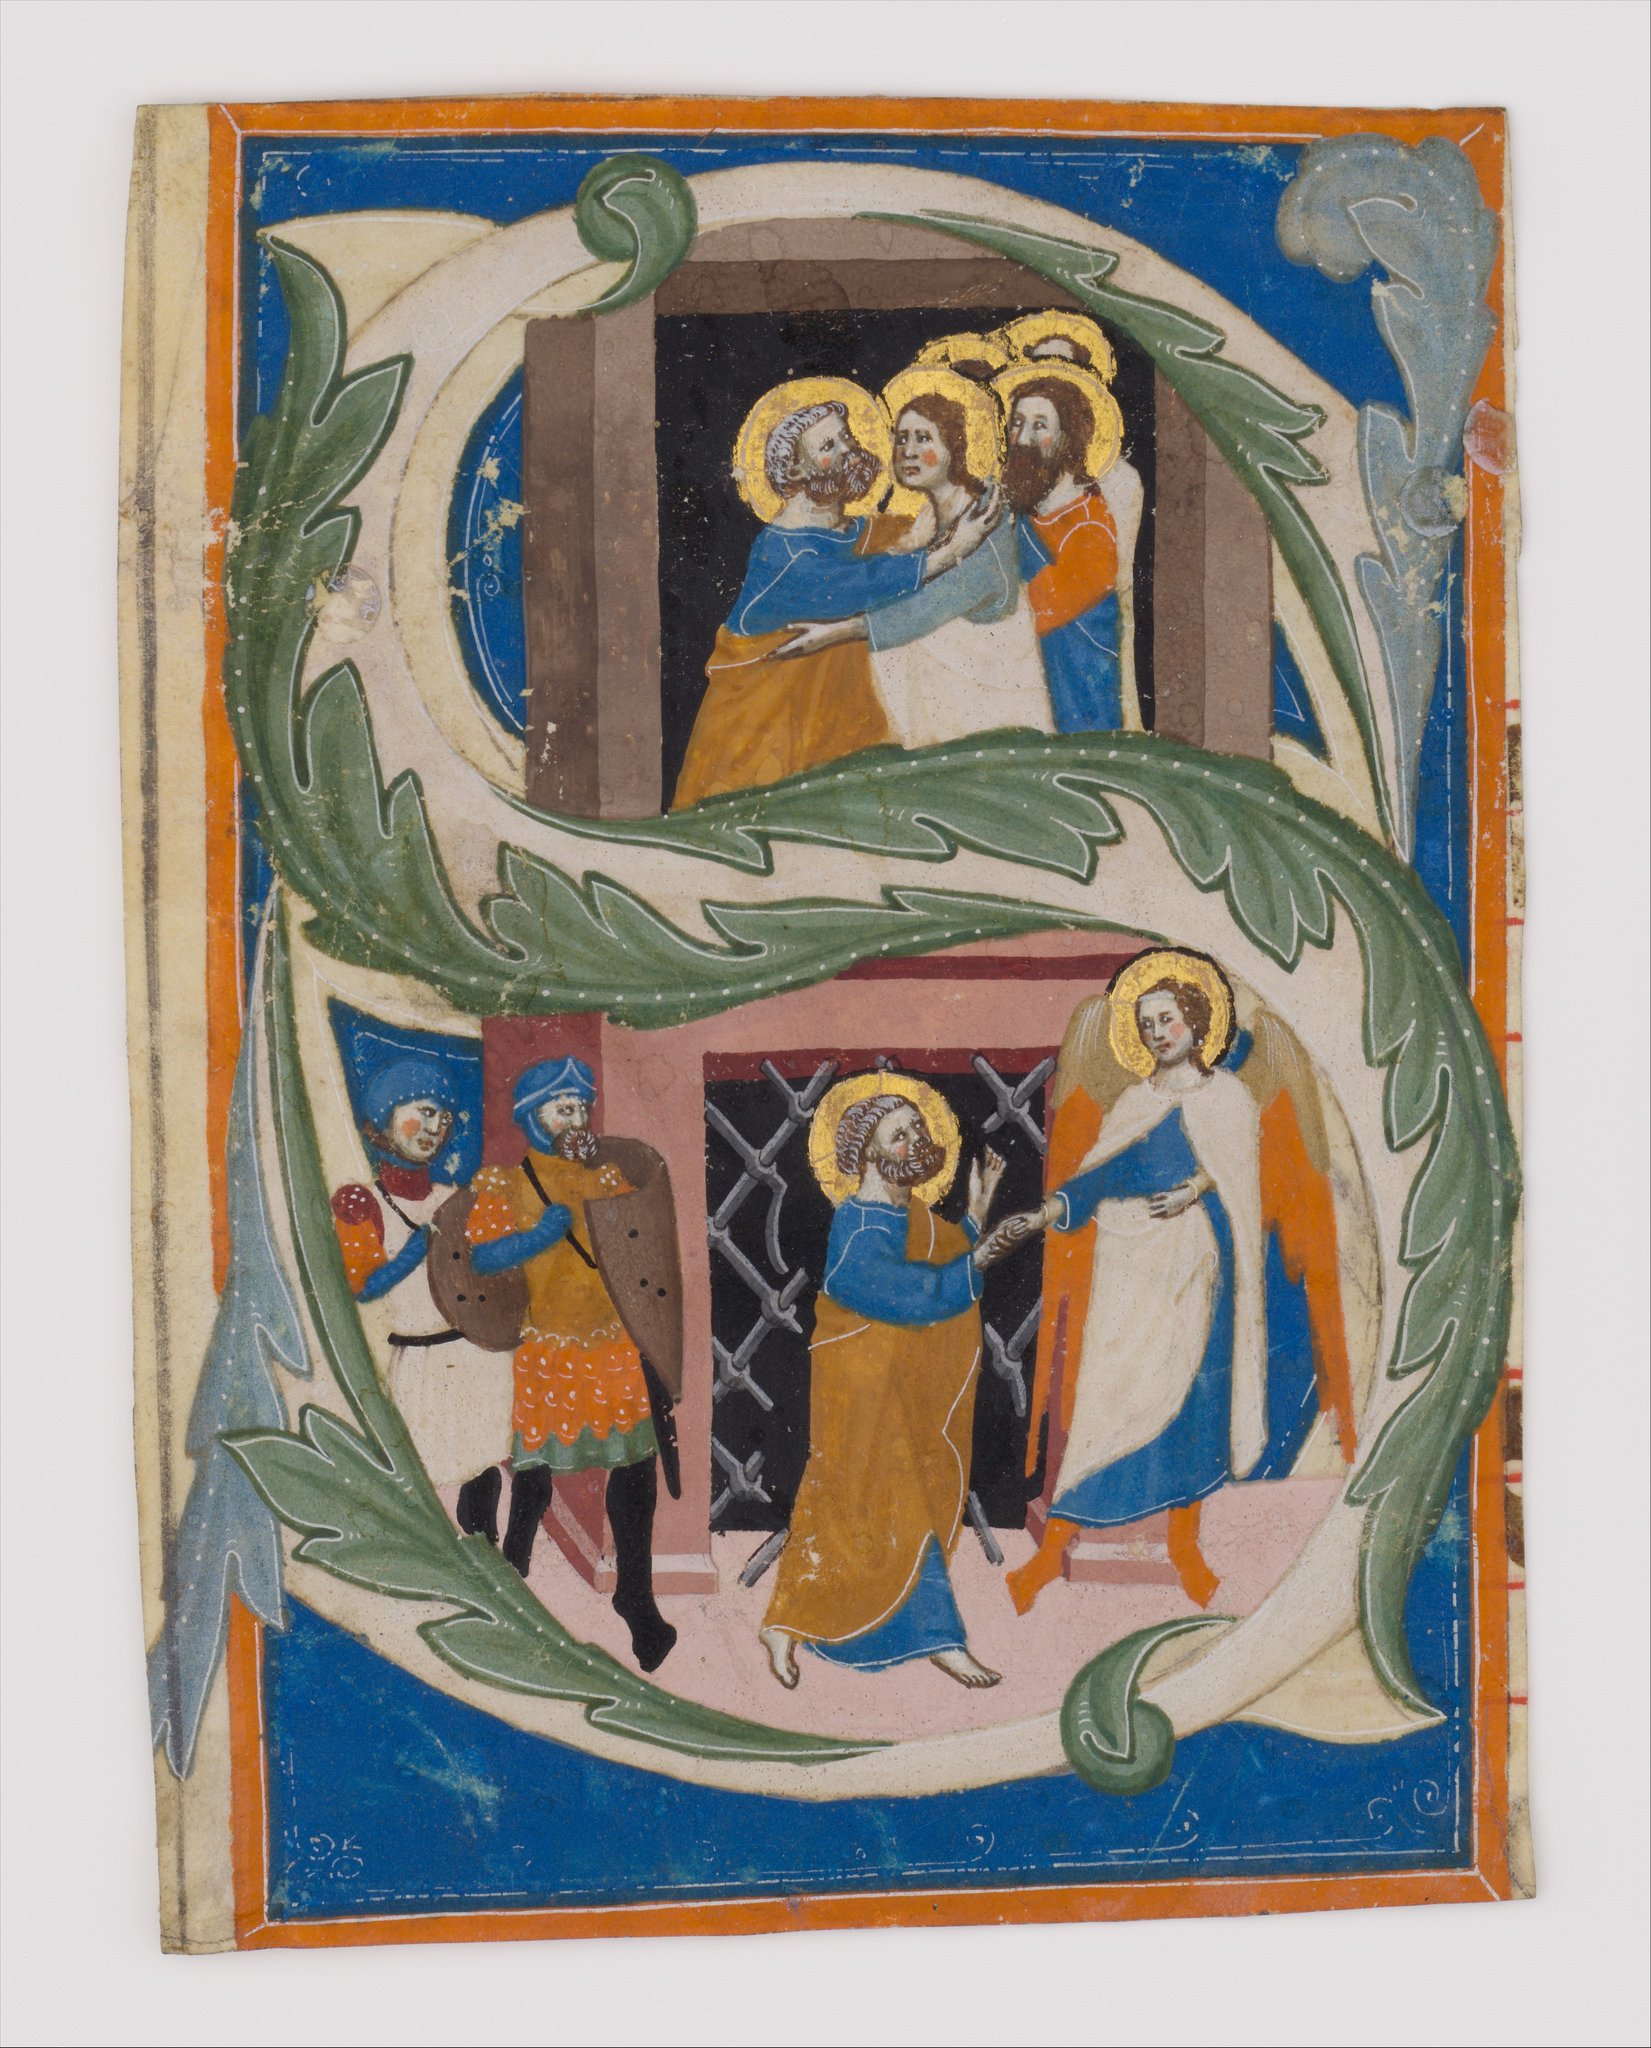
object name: manuscript cutting from an antiphonary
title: Initial S with Saint Peter Liberated from Prison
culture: italian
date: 1301-1350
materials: gold, ink, parchment, paint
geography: italy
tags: human figures,prisons,saint peter